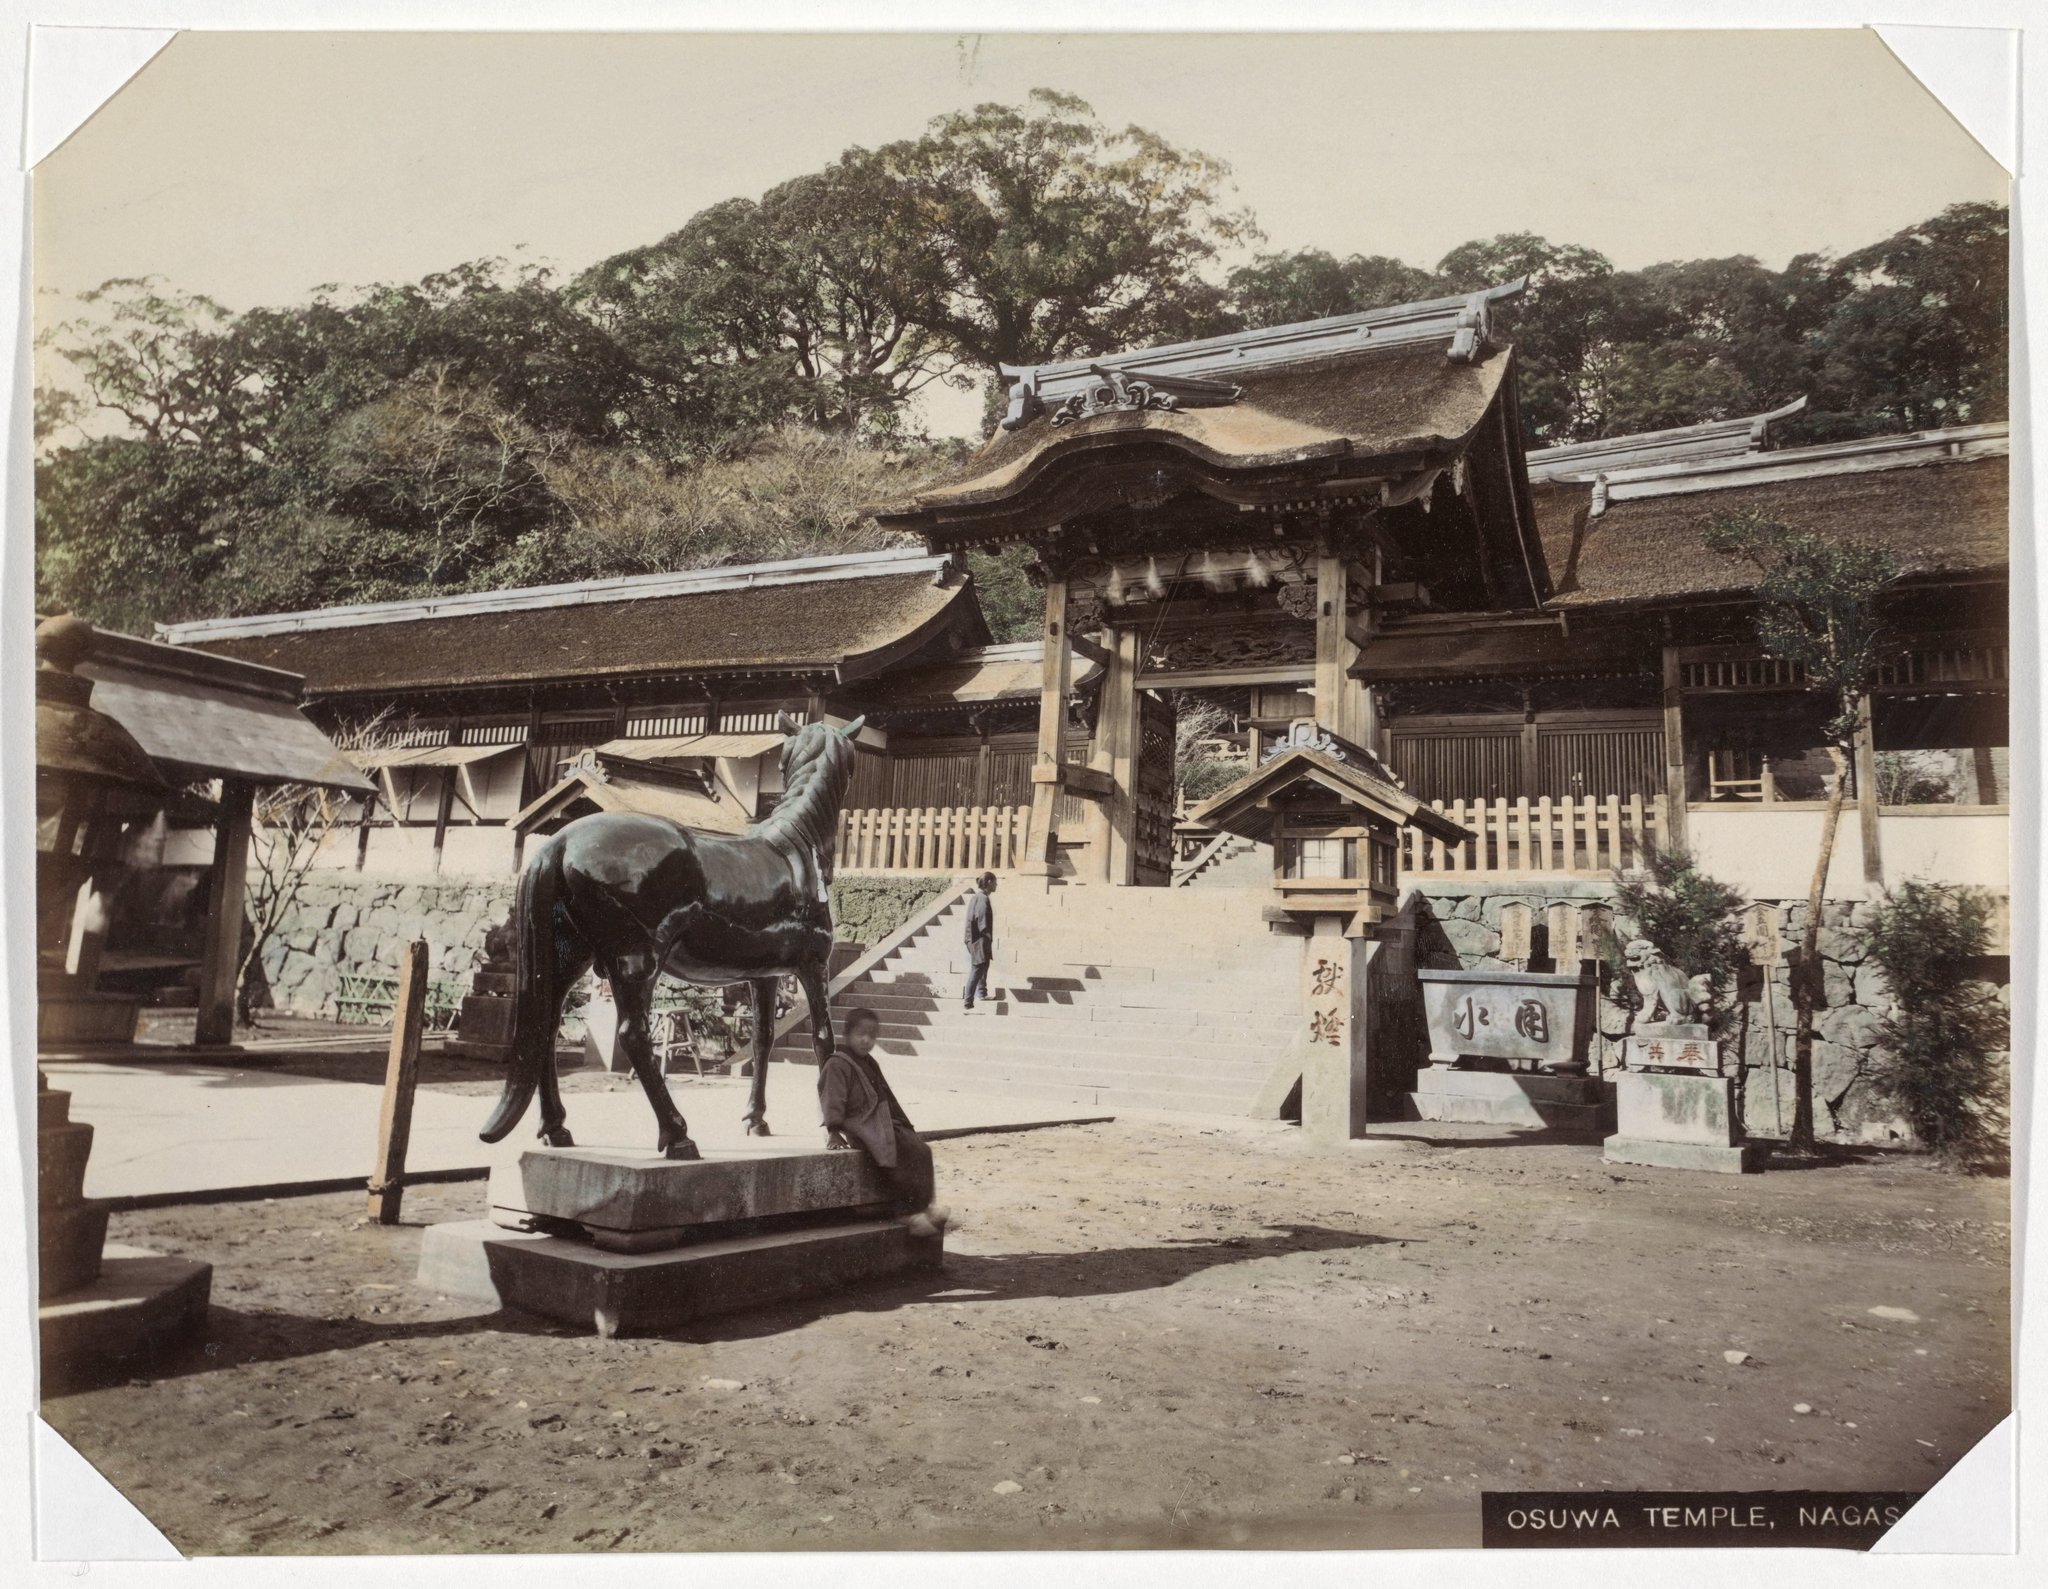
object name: photograph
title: Osuwa temple, Nagasaki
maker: Anonymous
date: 1890-1894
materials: cardboard, paper, photographic support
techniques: albumen print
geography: nagasaki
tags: temple, shrine ~ hinduism, buddhism, jainism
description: Onderdeel van Album met 69 foto's van een reis door Japan.